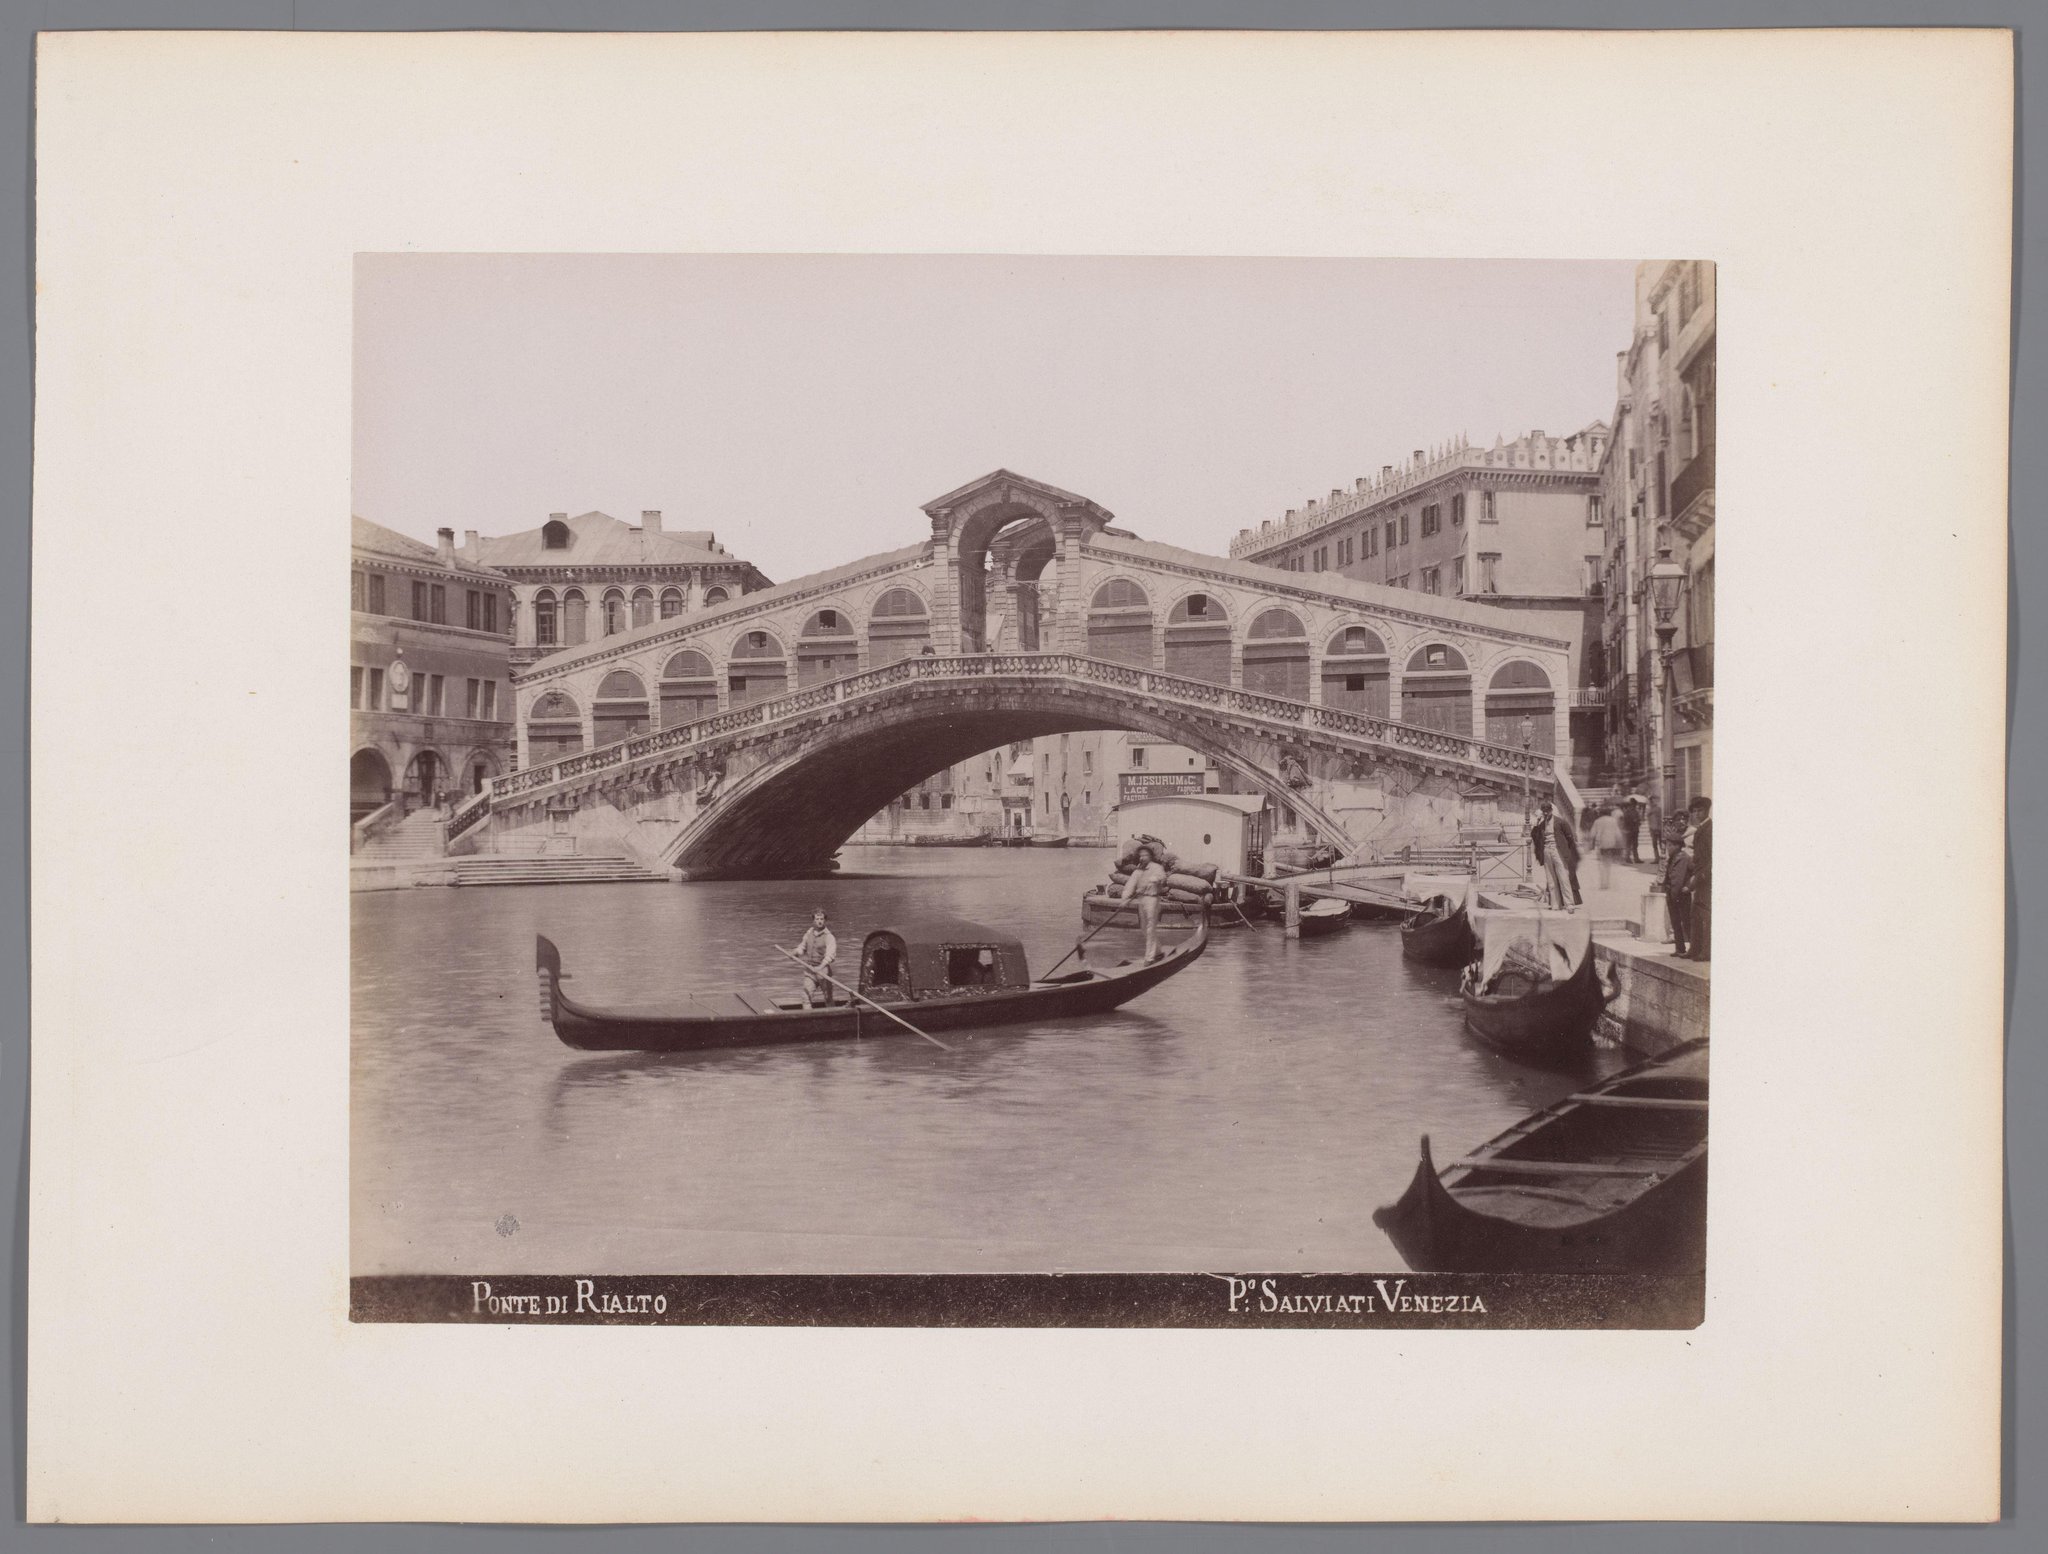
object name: photograph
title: Gondels op het Canal Grande voor de Rialtobrug te Venetië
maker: paolo salviati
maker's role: fotograaf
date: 1860-1870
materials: cardboard, paper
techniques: albumen print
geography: venice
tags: bridge in city across river, canal, etc., gondola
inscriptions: inscription: ‘Venetie’